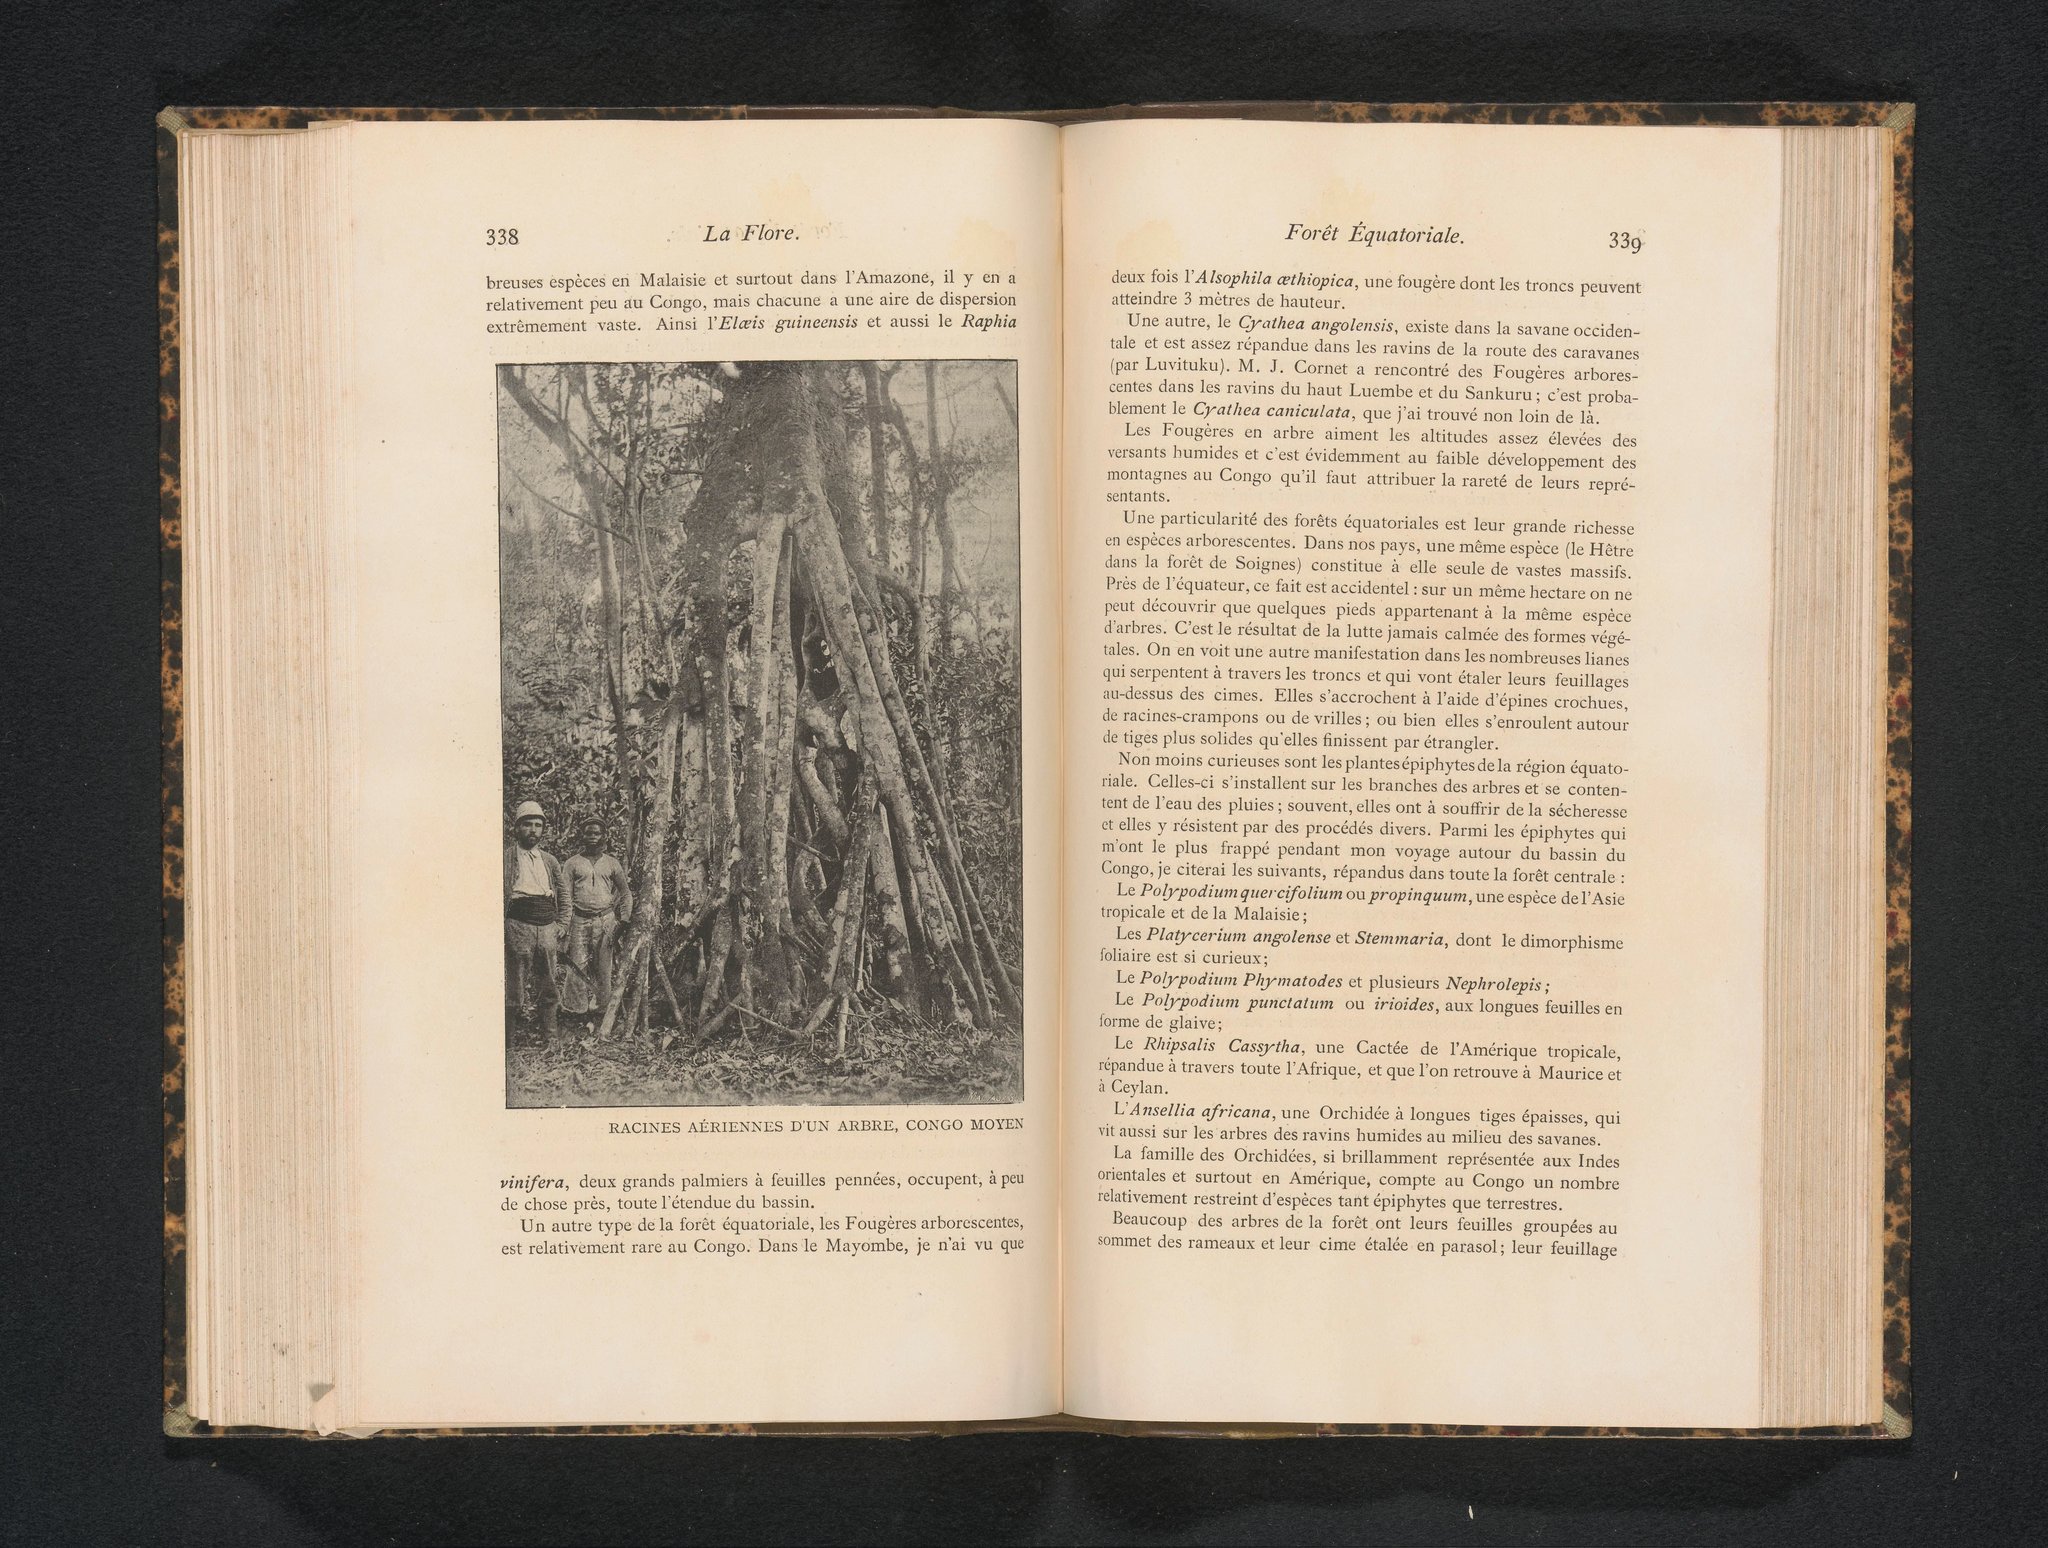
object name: photomechanical print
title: Twee mannen bij de wortels van een boom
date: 1887-1892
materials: paper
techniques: autotype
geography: congo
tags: trees, historical persons